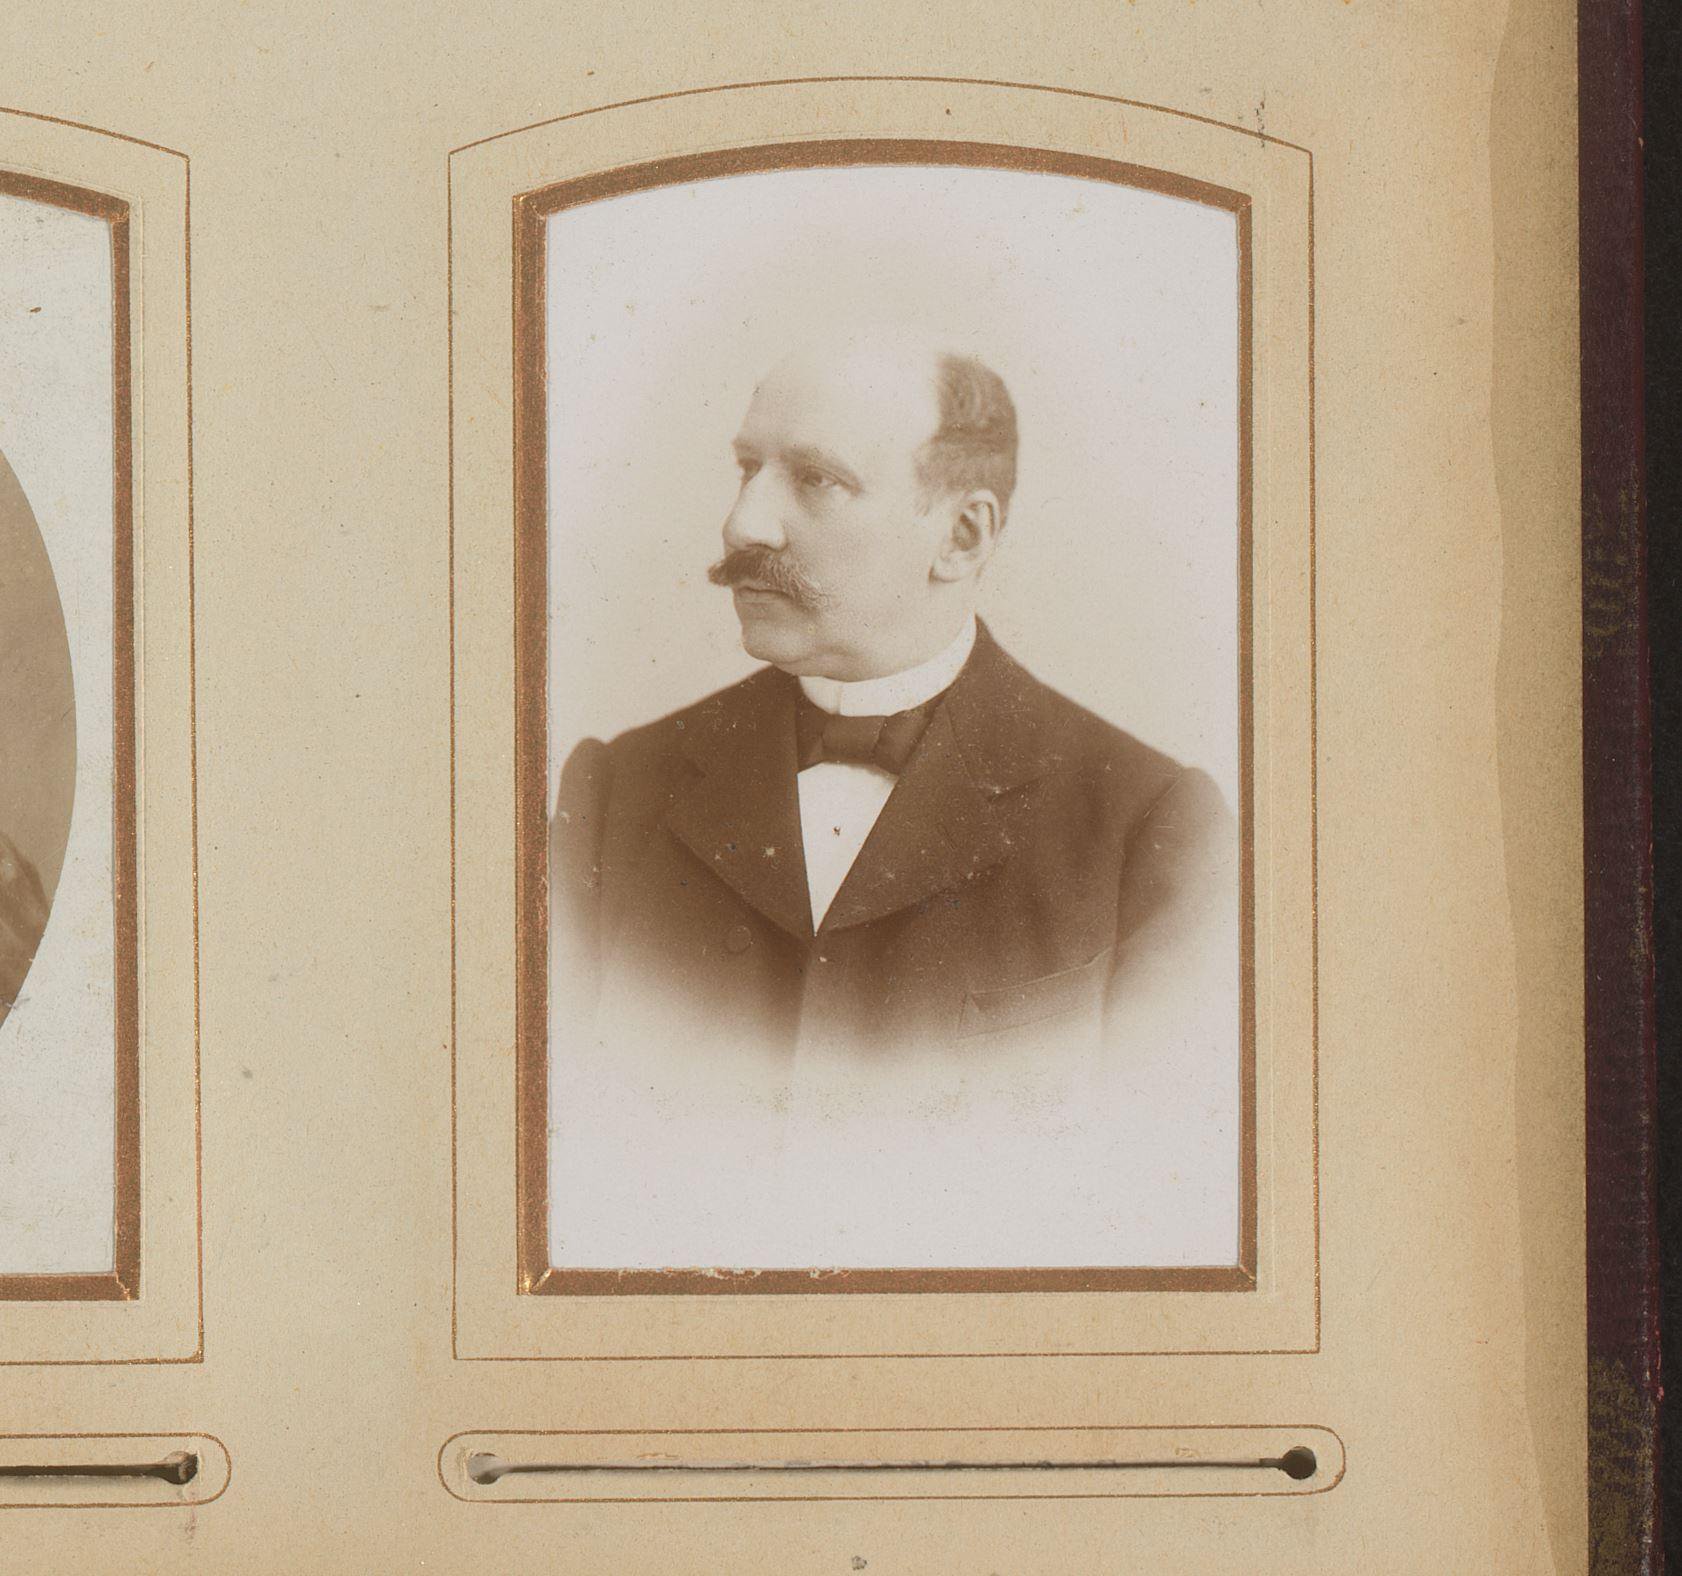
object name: album leaf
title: Portret van een man met snor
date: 1881-1903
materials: cardboard, photographic support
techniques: collodion silver print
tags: moustache, historical persons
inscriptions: inscription: ‘Cosman/ HOFPHOTOGRAAF/ Amsterdam/ Bad Kleef.’